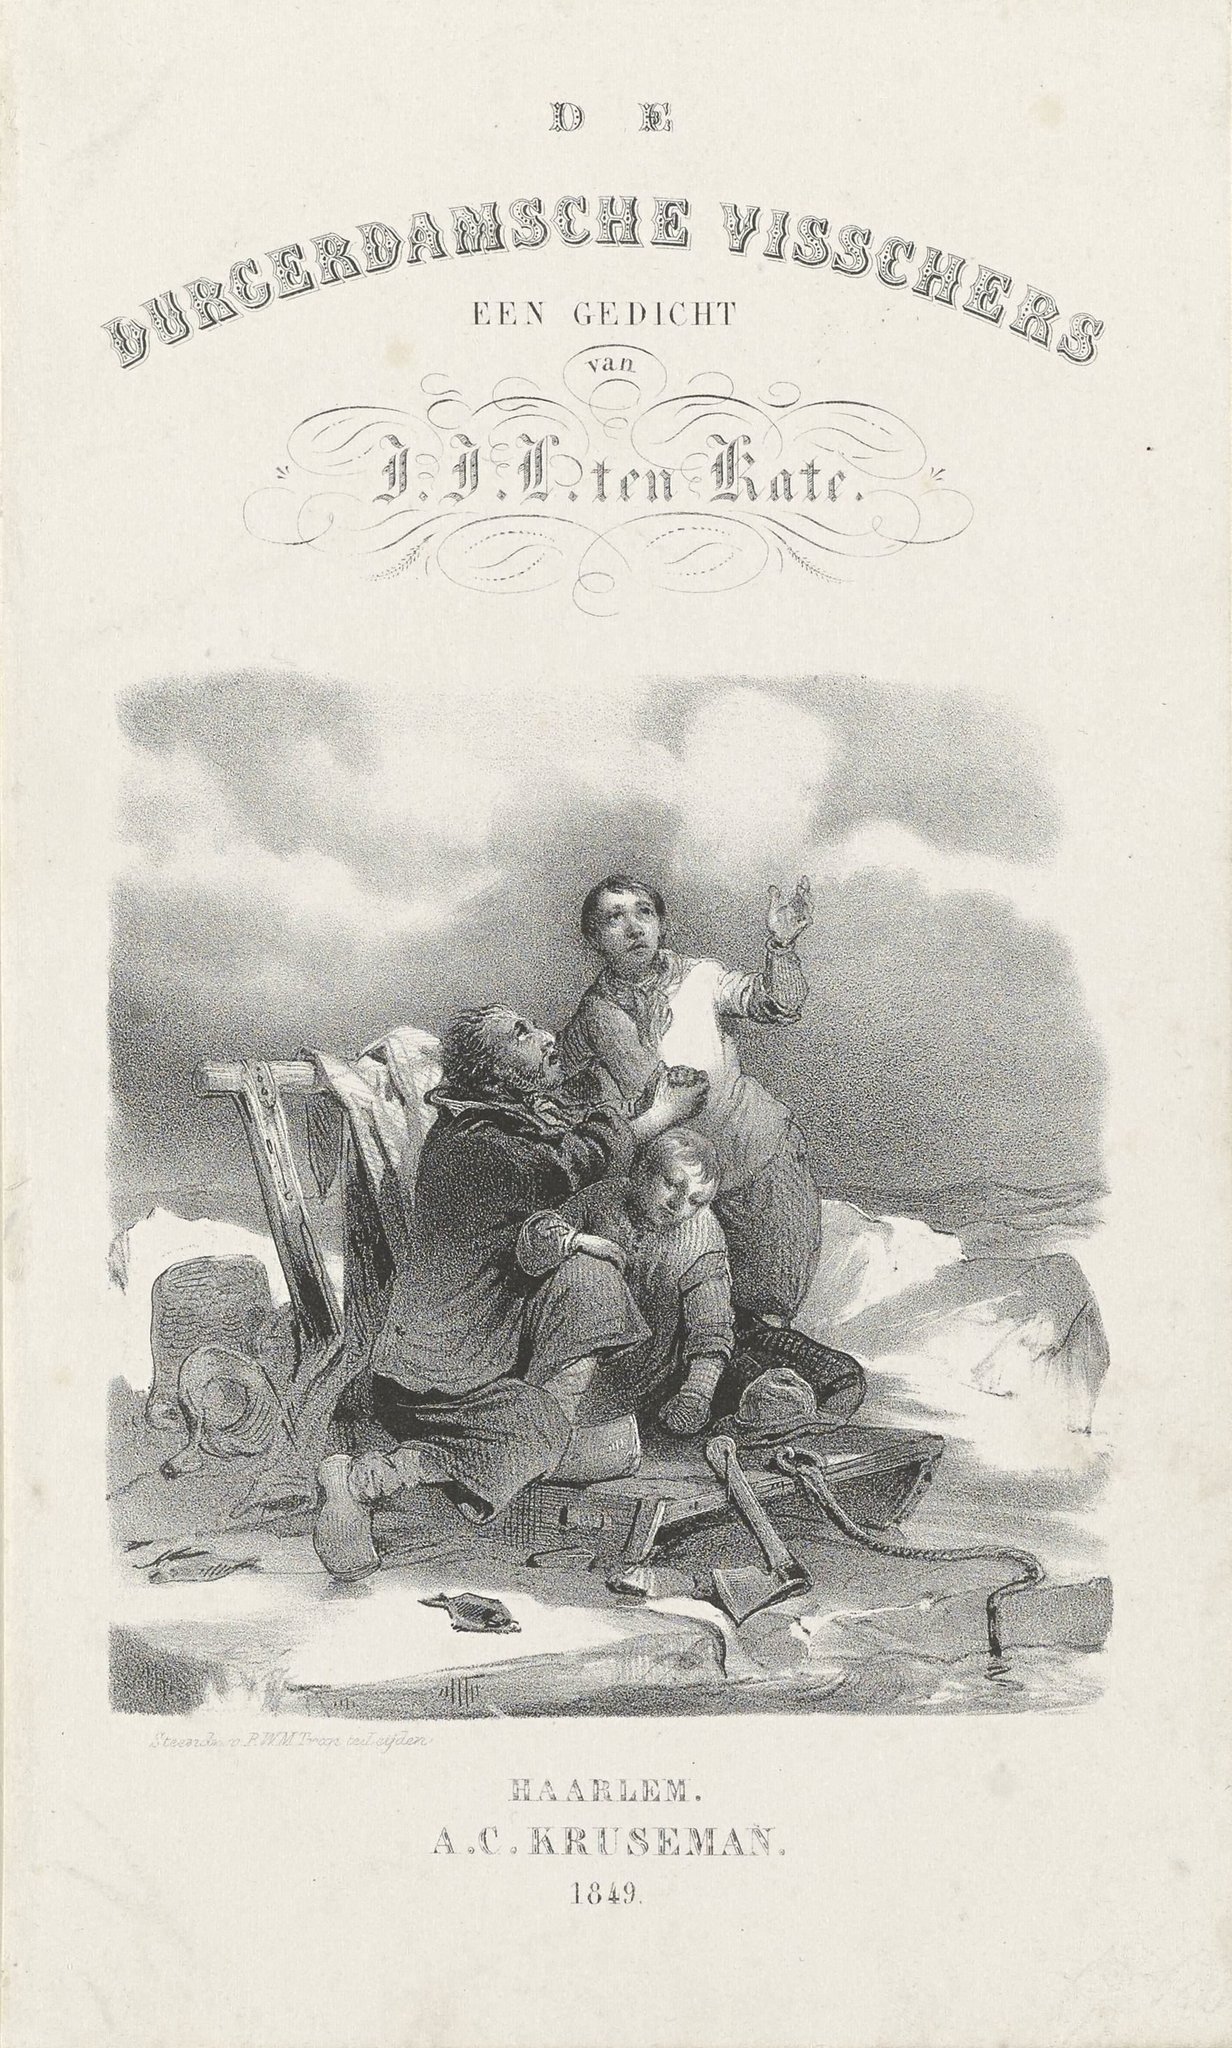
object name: print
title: Titelpagina voor 'De Durgerdamsche Visschers', van J.J.L. ten Kate, 1849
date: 1849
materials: paper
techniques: lithograph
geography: haarlem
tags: saving a person from drowning, drift ice, zuiderzee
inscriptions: collector's mark: Lugt 2228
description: Titelpagina voor 'De Durgerdamsche Visschers', van J.J.L. ten Kate, 1849. Een gedicht over Klaas Bording en zijn twee zoons uit Durgerdam die tussen 13-27 januari 1849 veertien dagen op een ijsschots op de Zuiderzee dreven. De vader met zijn zoons op hun ijsslede op een ijsschots.